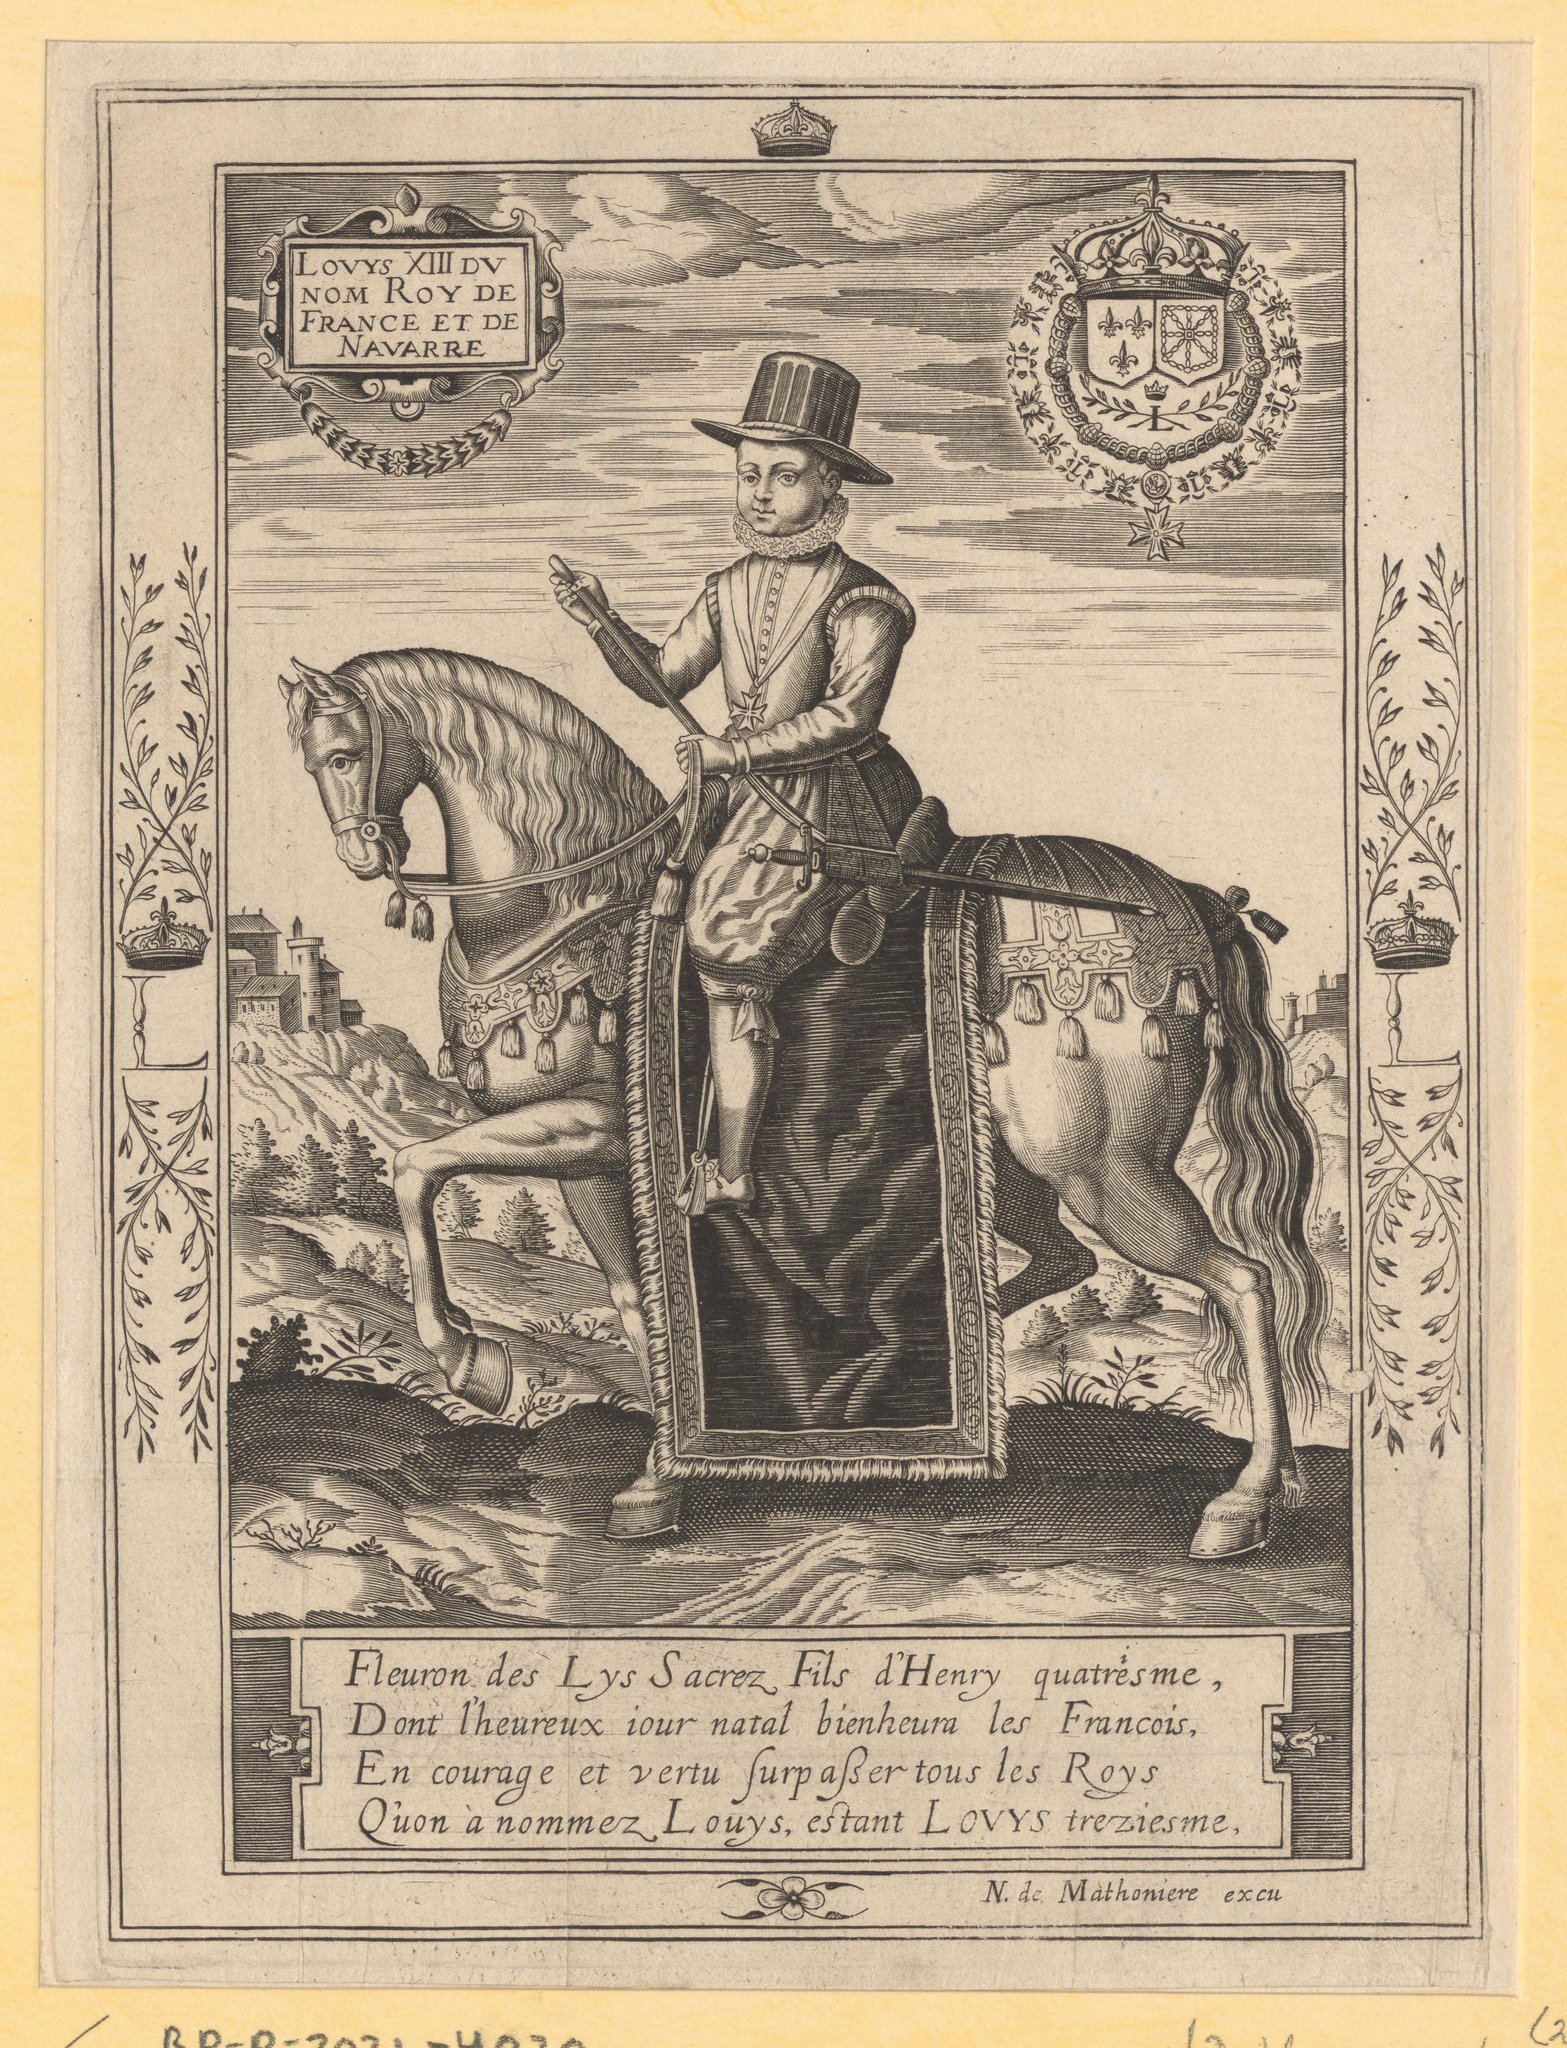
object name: print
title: Ruiterportret van Lodewijk XIII van Frankrijk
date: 1610-1615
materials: paper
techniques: engraving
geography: france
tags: lodewijk xiii (koning van frankrijk), equestrian state-portrait, historical persons, king, armorial bearing, heraldry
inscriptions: collector's mark: Lugt 2228